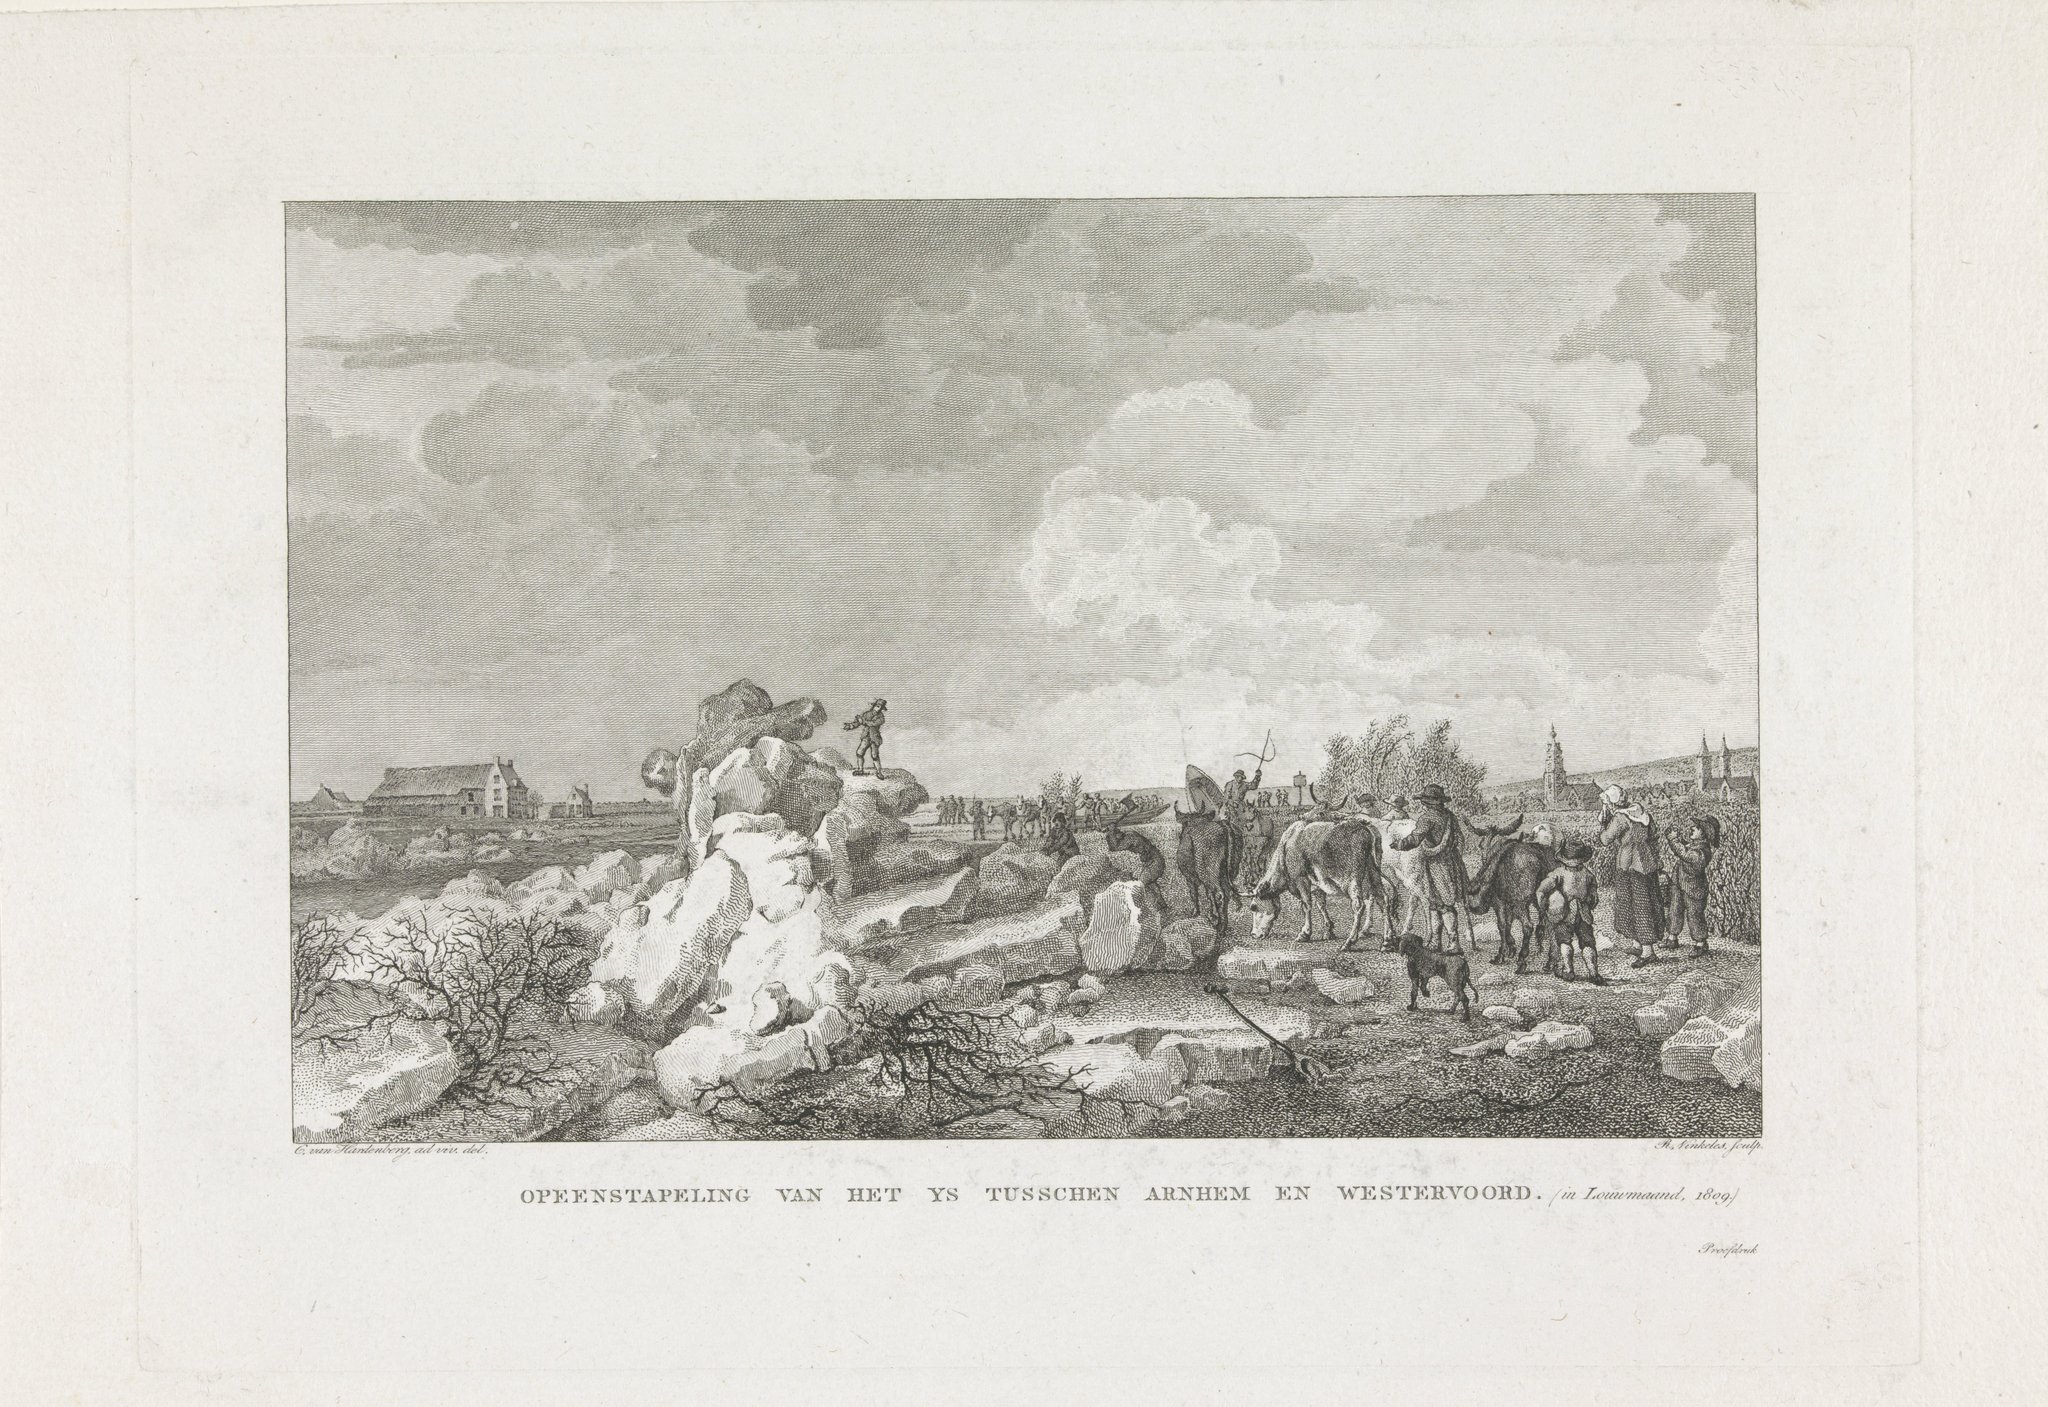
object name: print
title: Opeenstapeling van het ys tusschen Arnhem en Westervoord. (in Louwmaand, 1809.)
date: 1809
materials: paper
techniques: engraving, etching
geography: netherlands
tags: dike-break, drift ice, arnhem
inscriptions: collector's mark: Lugt 2228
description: Gebruikt als illustratie in: Hendrik Ewijk. Geschiedkundig verslag der dijkbreuken en overstroomingen, langs de rivieren in het Koningrijk Holland, voorgevallen in louwmaand MDCCCIX. 3 dln. Amsterdam: Johannes Allart en Jacobus Ruys, 1809.